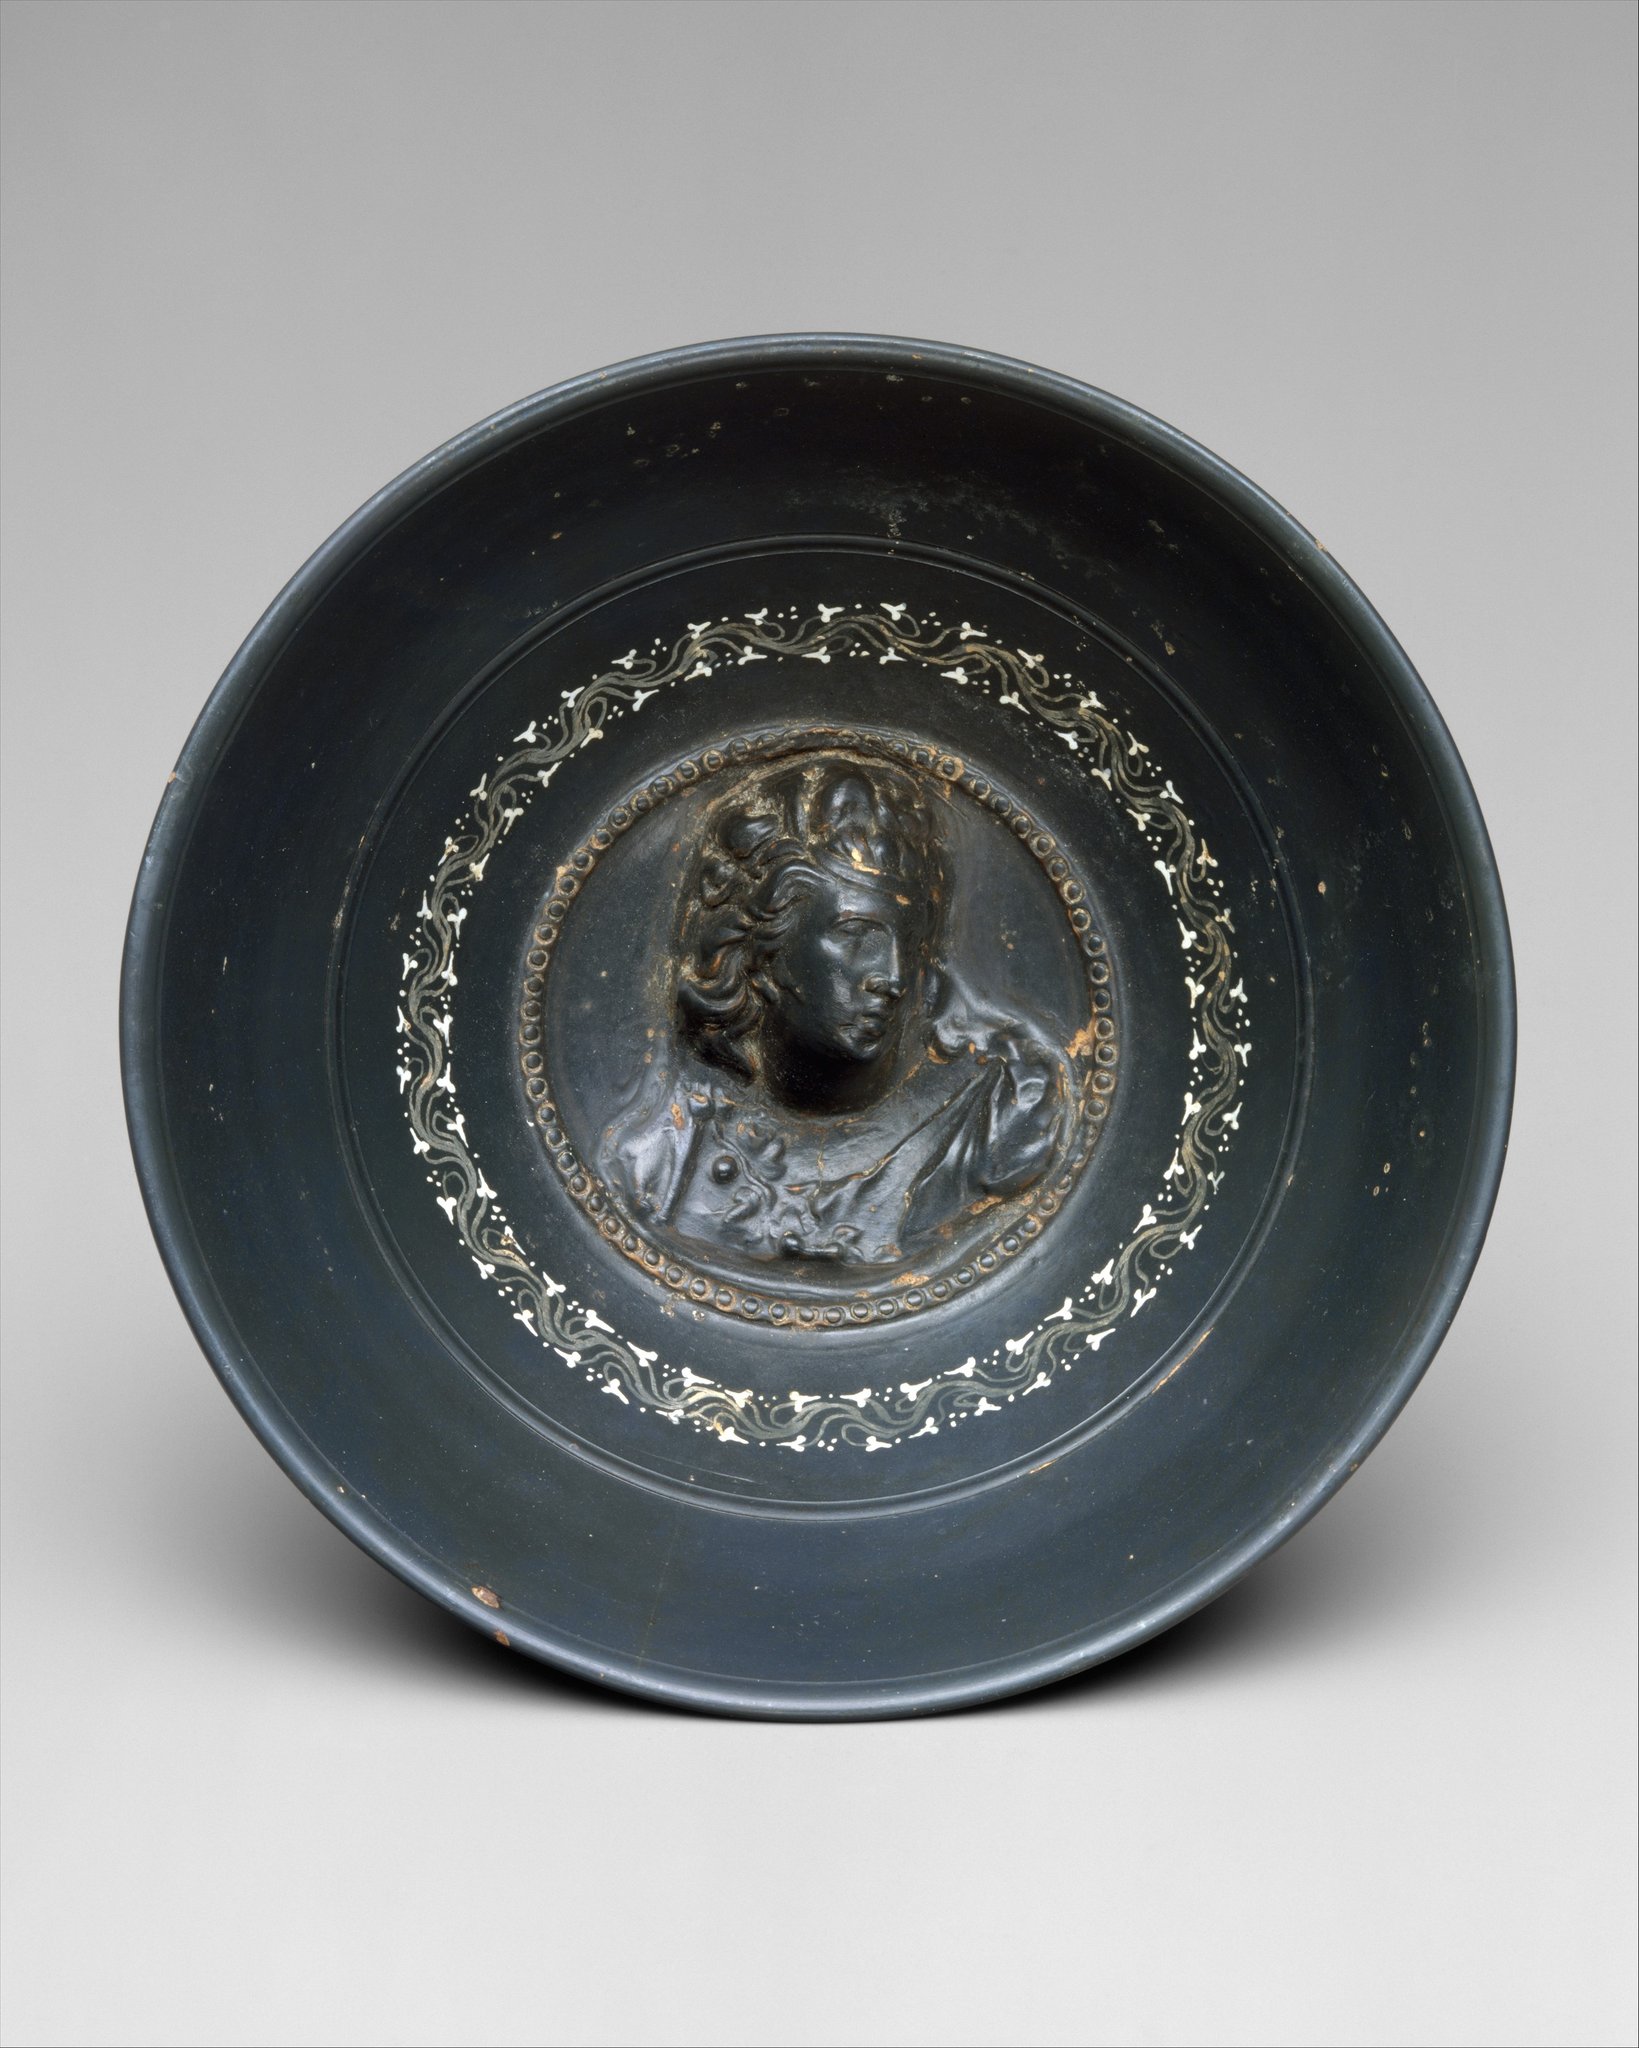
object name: bowl, deep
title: Terracotta deep bowl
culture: greek, calenian or campanian or south italian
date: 234-168 BCE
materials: terracotta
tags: dionysus